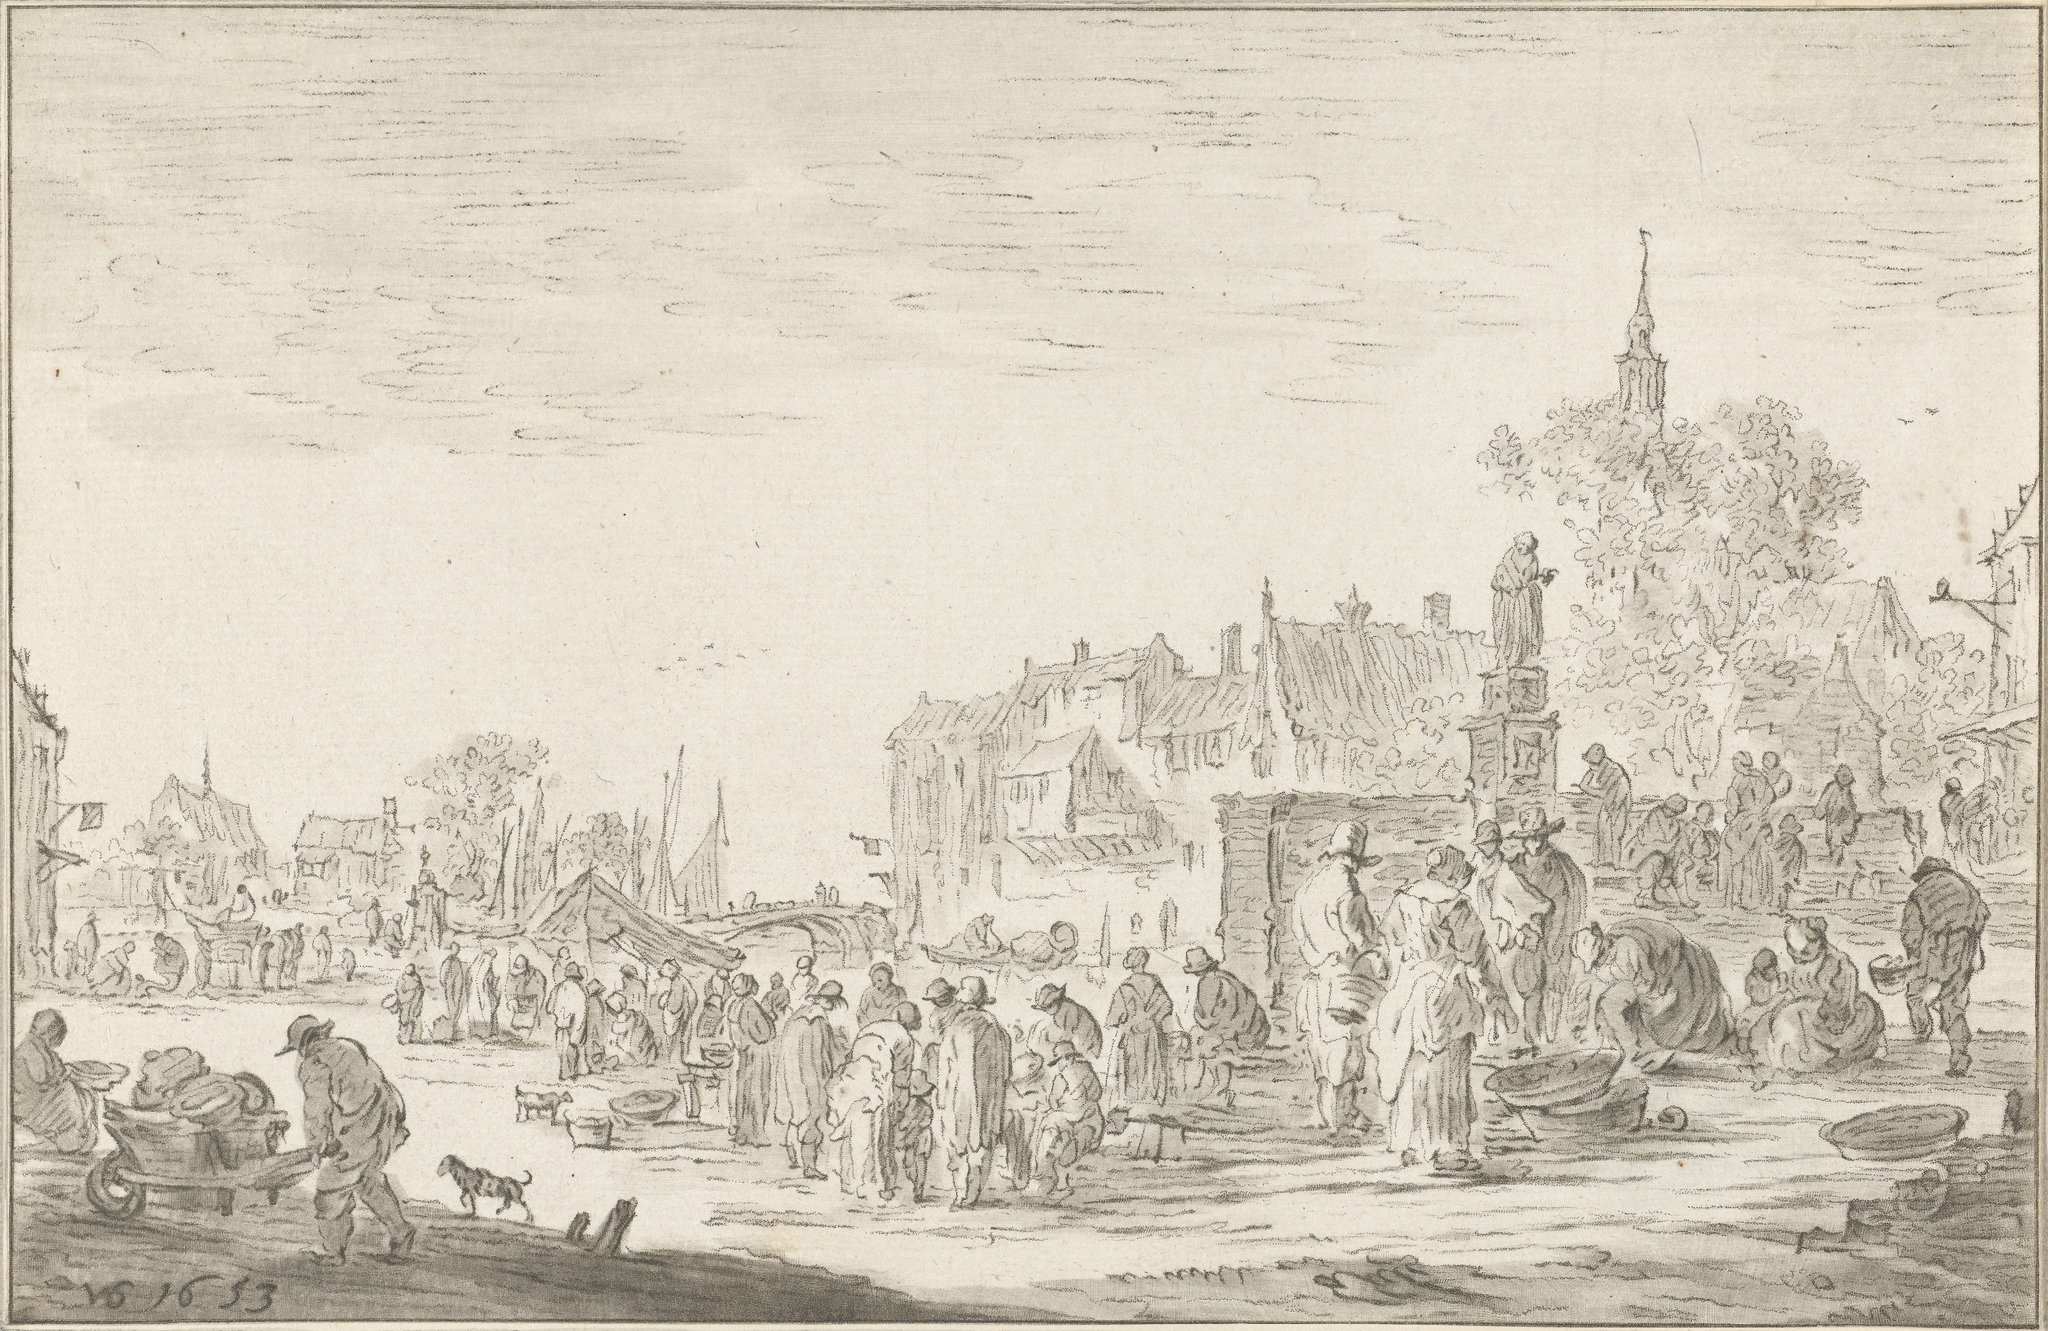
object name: print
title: Vismarkt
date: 1767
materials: paper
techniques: printmaking, roulette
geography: amsterdam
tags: market, commercial fishery (+ trade ~ crafts, industries, agriculture)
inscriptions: collector's mark: Lugt 2228, inscription: ‘Jan Josephszoon van Goijen. del. 1653.Ploos van Amstel. fecit. 1767.’, collector's mark: Lugt 2725, collector's mark: Lugt 240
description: Bij het water in een stad komen mensen bijeen om vis te kopen en te verkopen. Rechts een standbeeld.